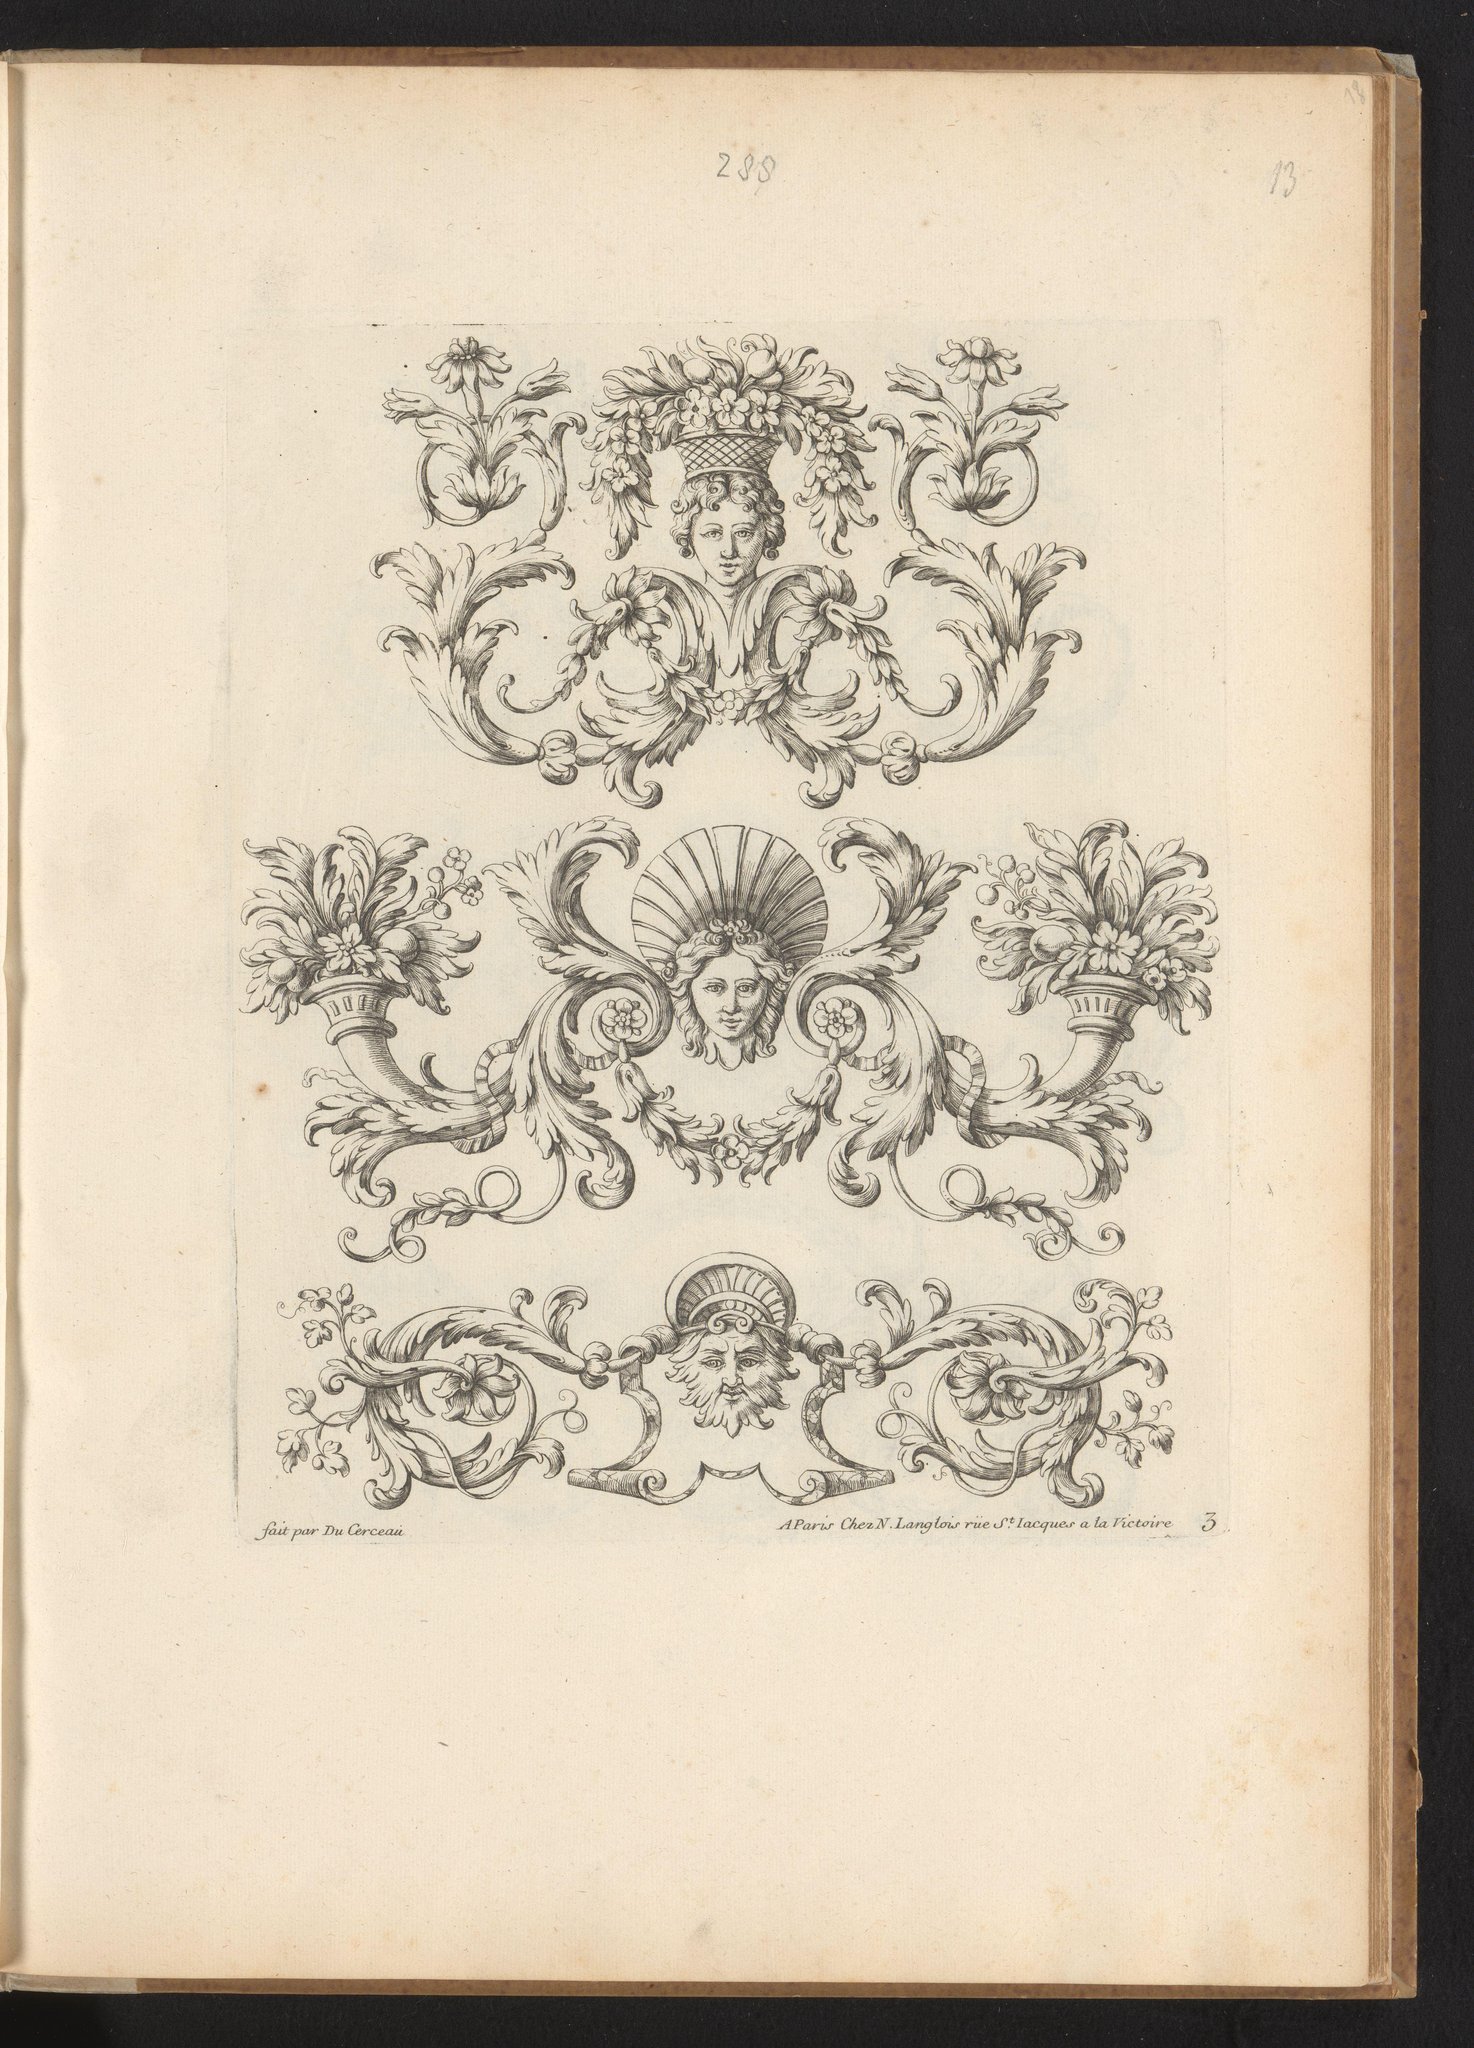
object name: ornament print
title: Modieuze ornamenten met bladmotieven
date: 1670-1690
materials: paper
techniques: etching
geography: paris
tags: acanthus ~ ornament, mask, mascaron ~ ornament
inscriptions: collector's mark: Lugt 2228a, collector's mark: Lugt 2760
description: Deze prent maakt deel uit van een album.